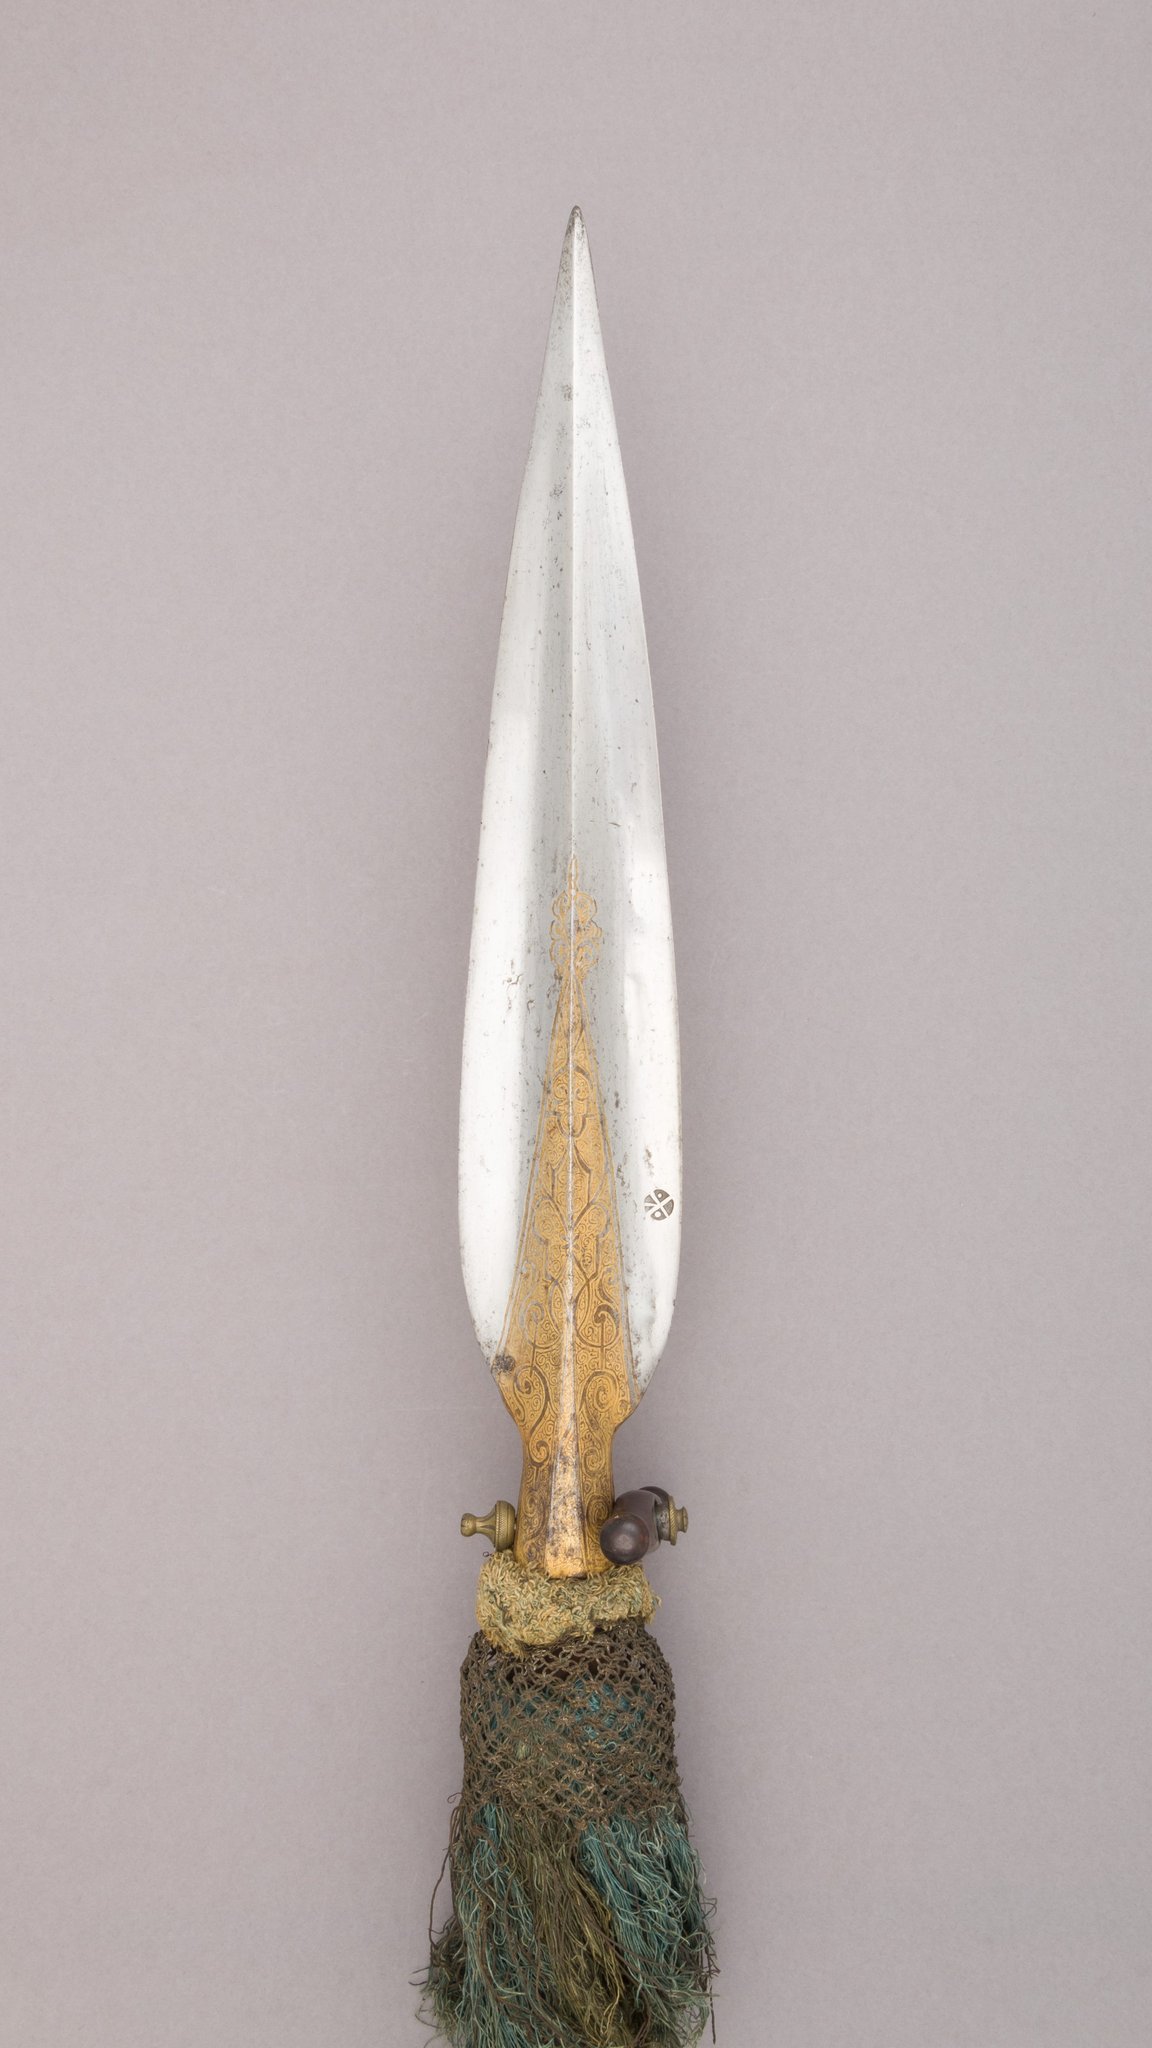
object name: boar spear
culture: german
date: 1501-1600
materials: gold, metal thread, steel, wood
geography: germany